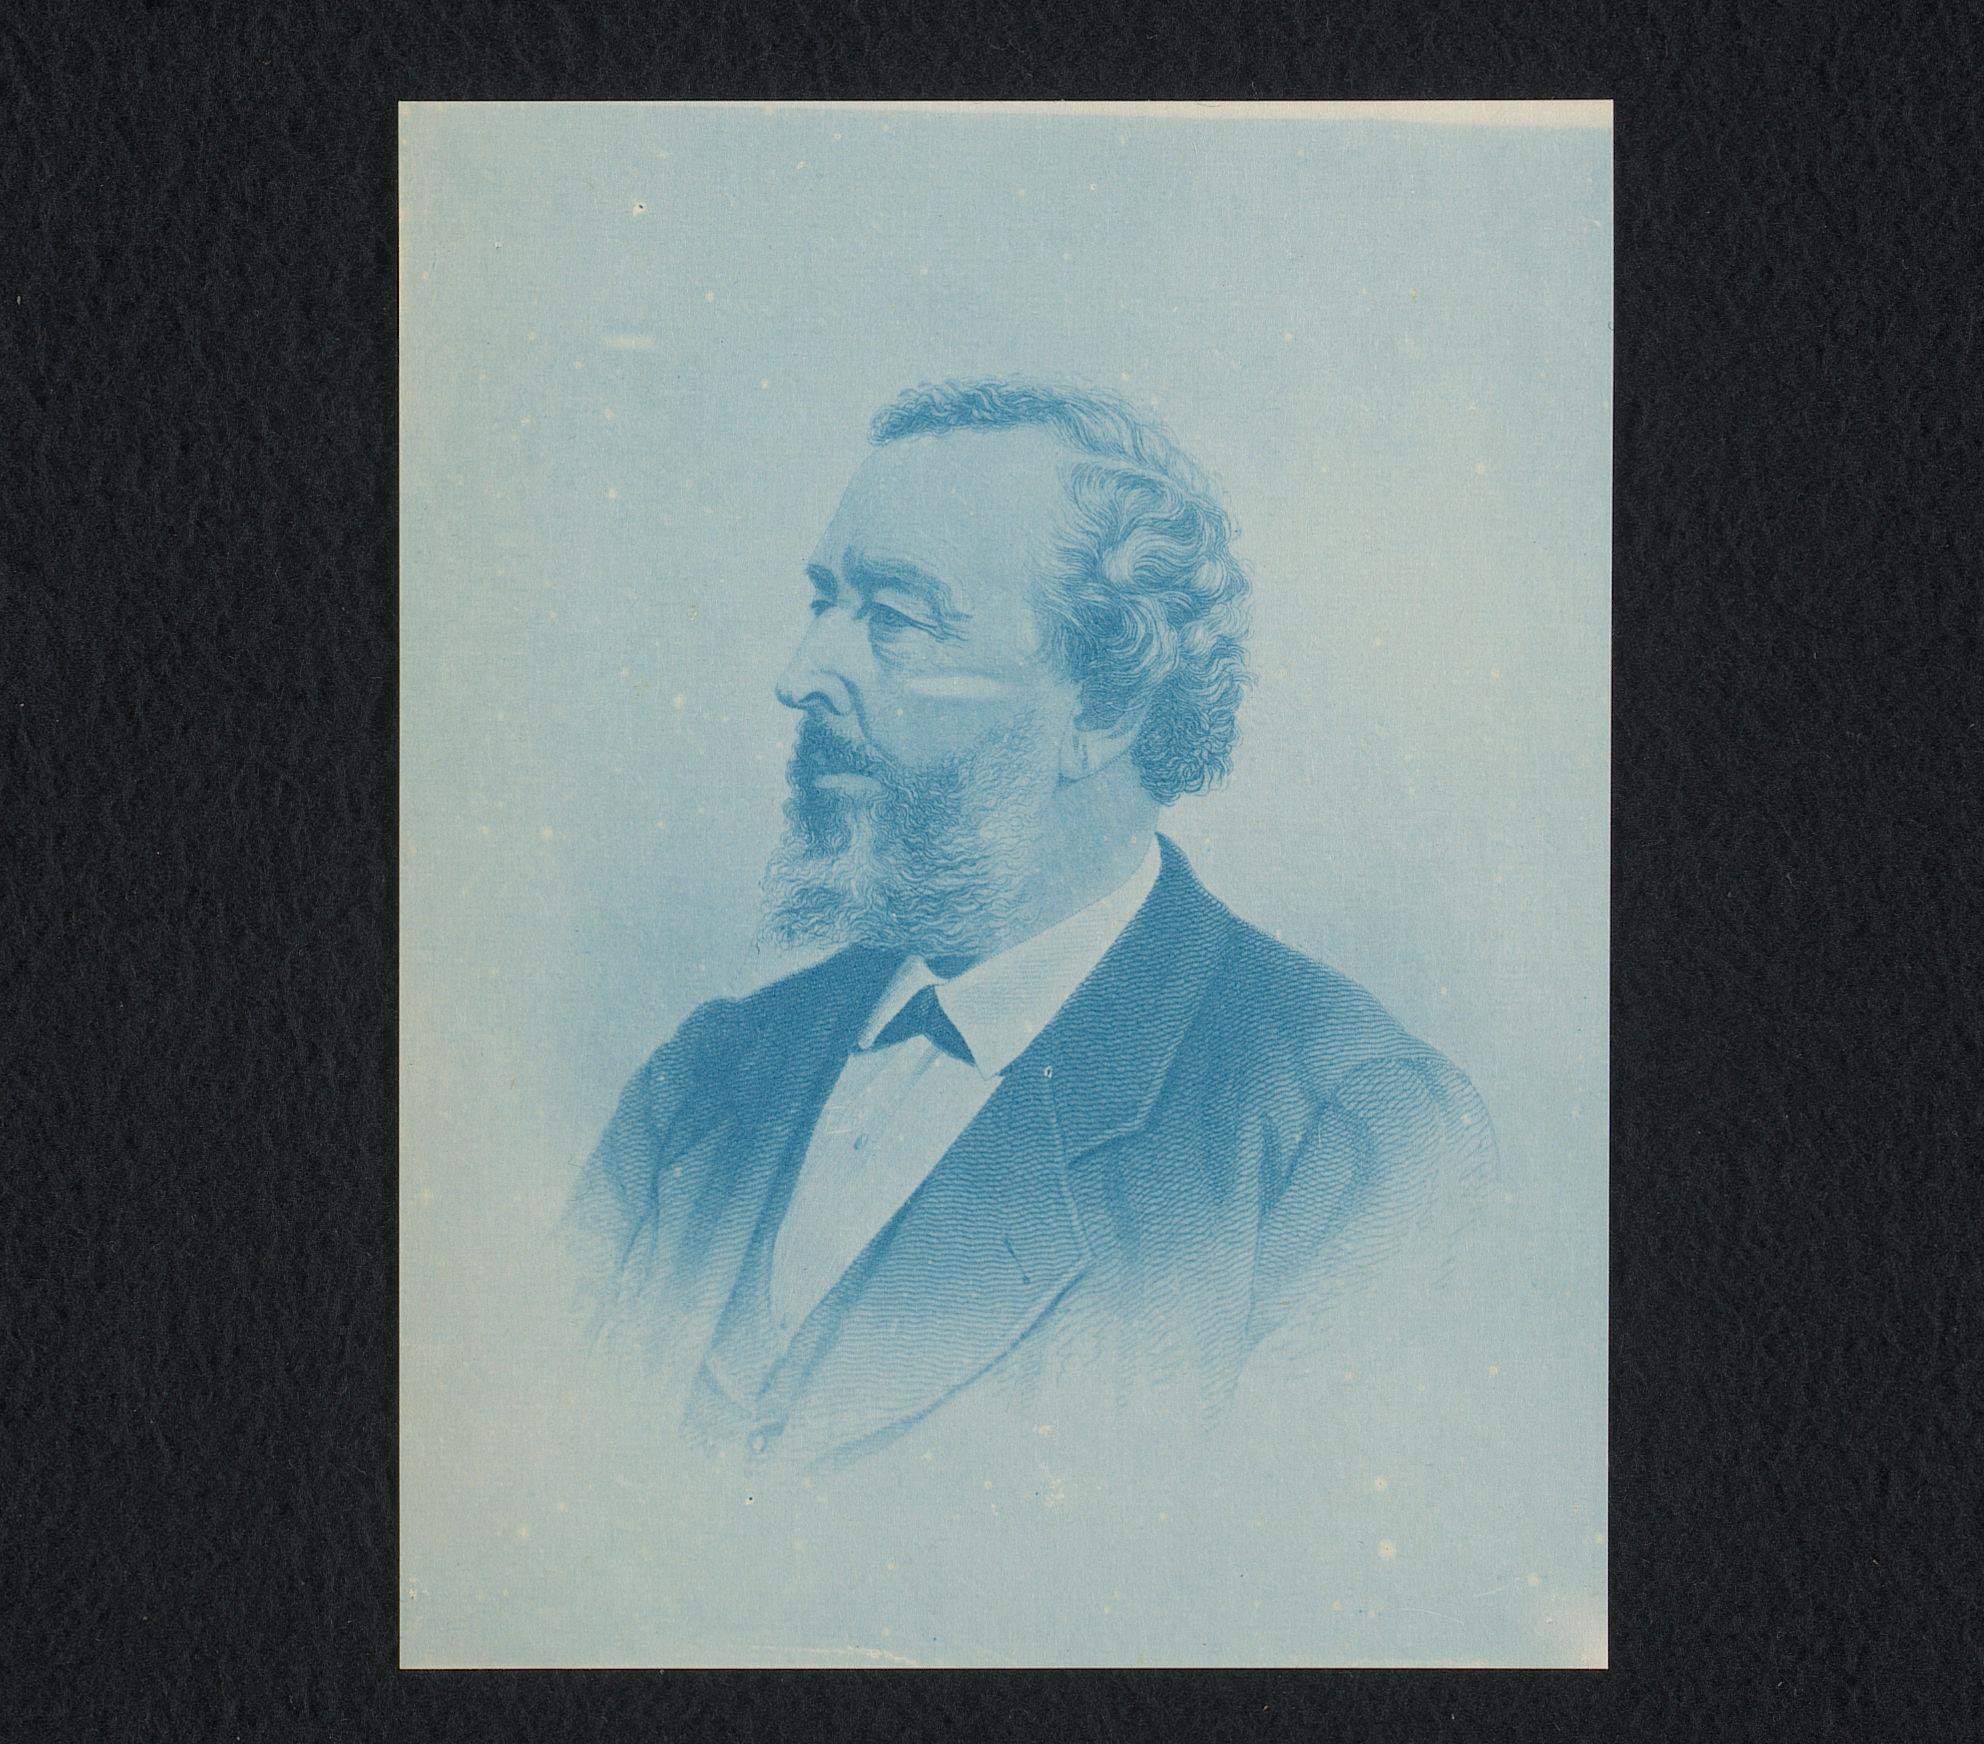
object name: photograph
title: Fotoreproductie van een prent van een portret van een onbekende man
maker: Anonymous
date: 1901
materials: paper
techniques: cyanotype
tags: historical persons not known by name